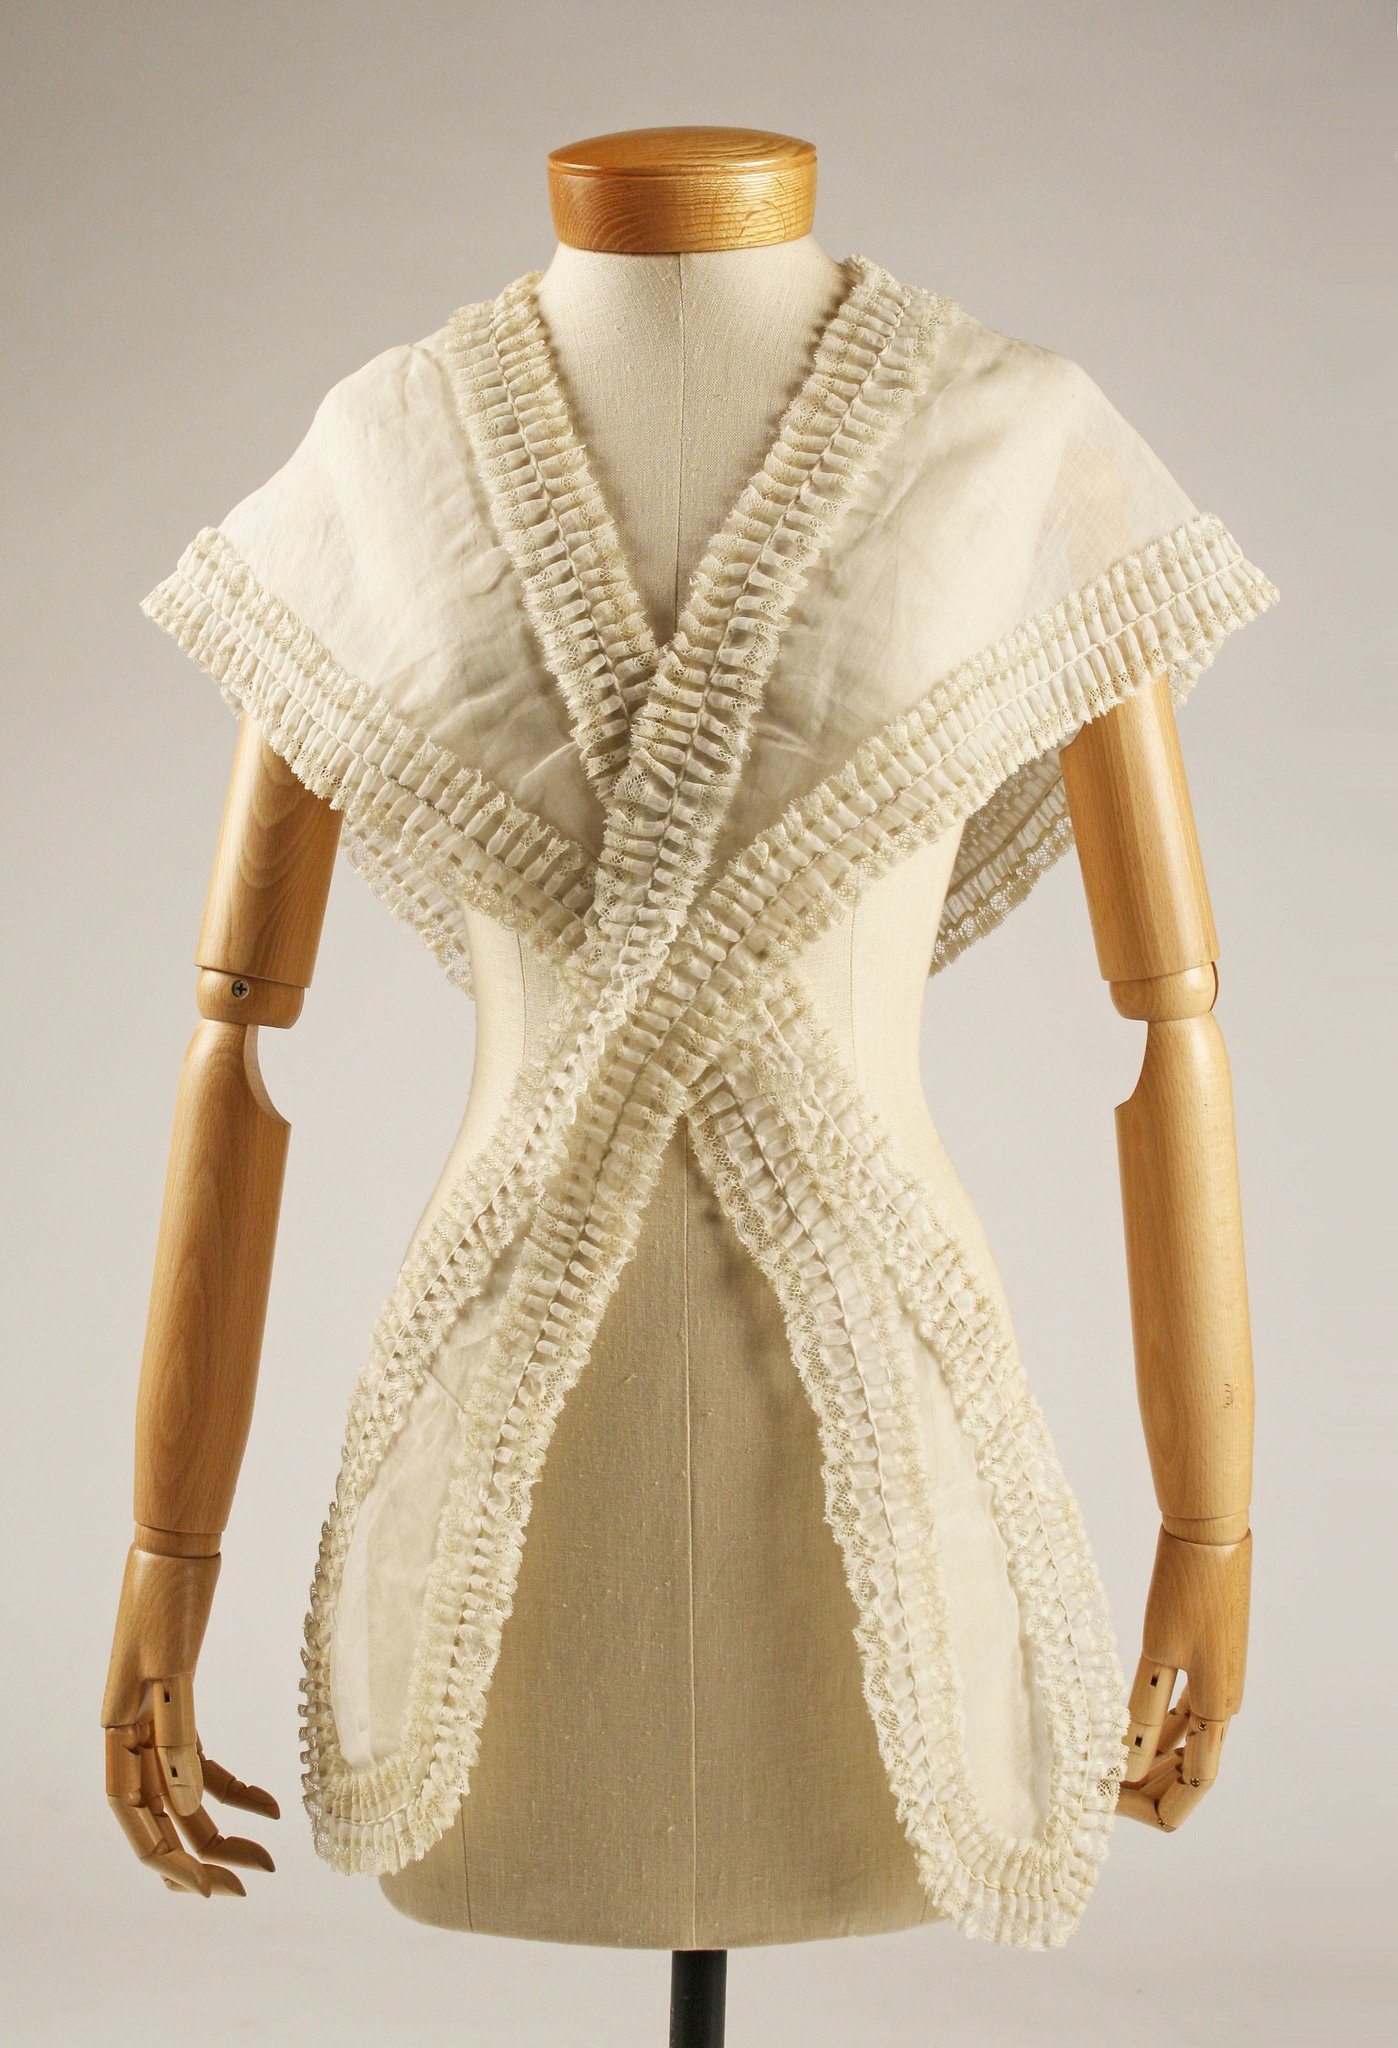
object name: fichu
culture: american or european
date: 1834-1866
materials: cotton